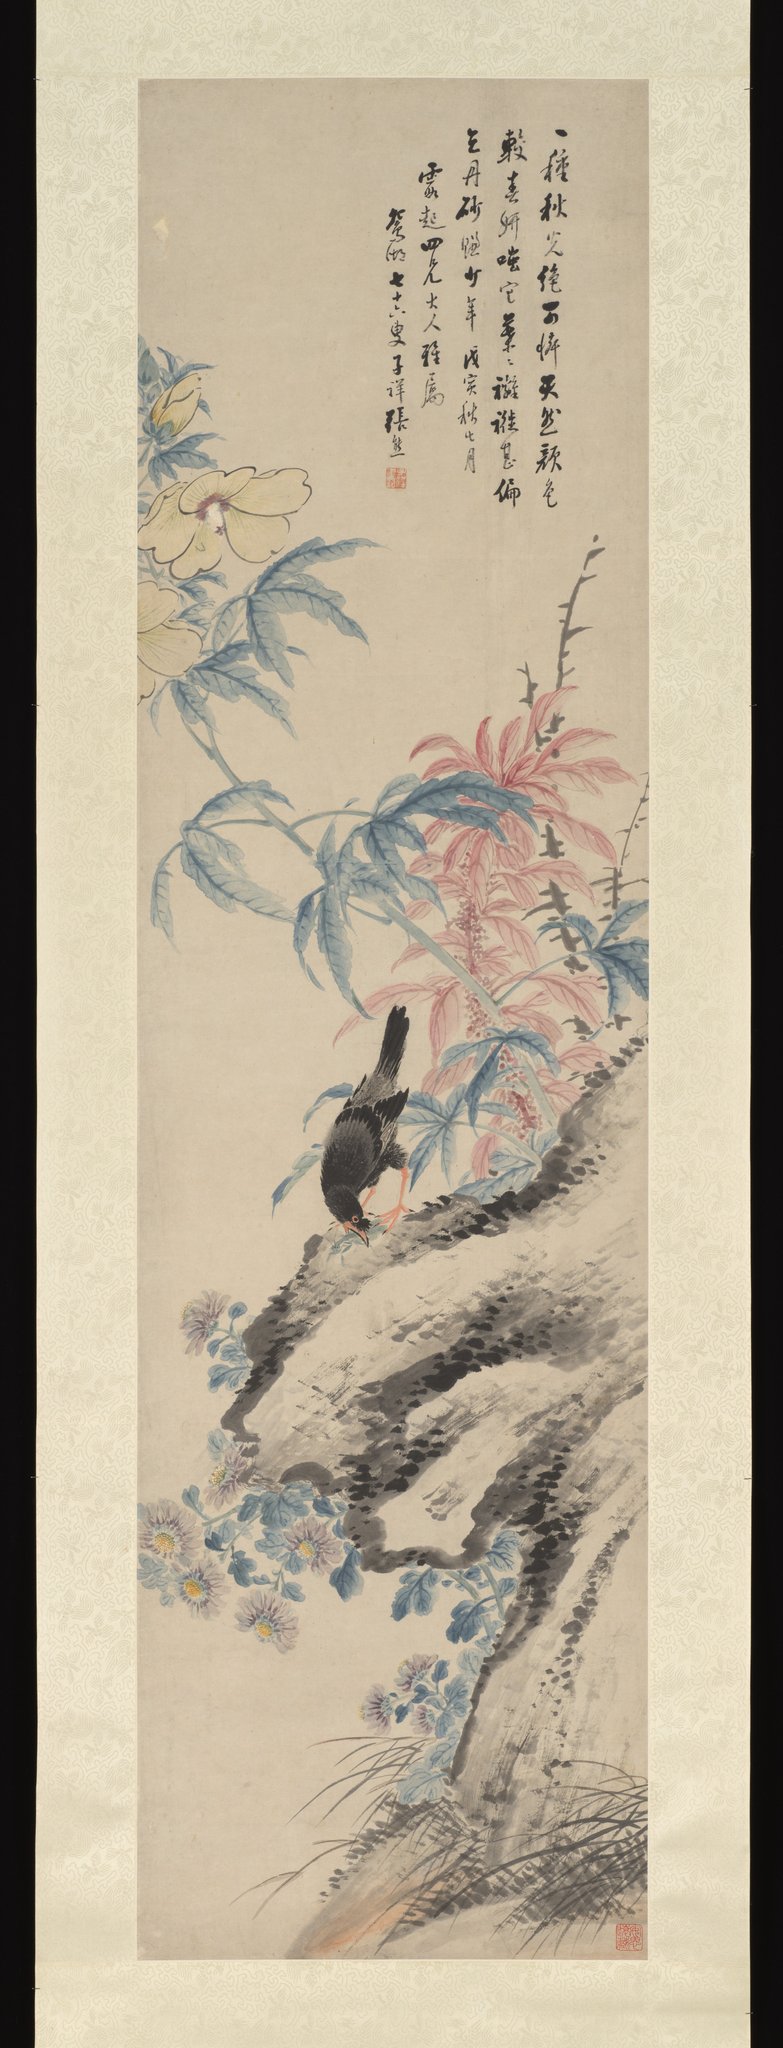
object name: hanging scroll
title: Flower and Bird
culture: chinese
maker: zhang xiong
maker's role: artist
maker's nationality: chinese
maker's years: 1803-1886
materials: ink, paper